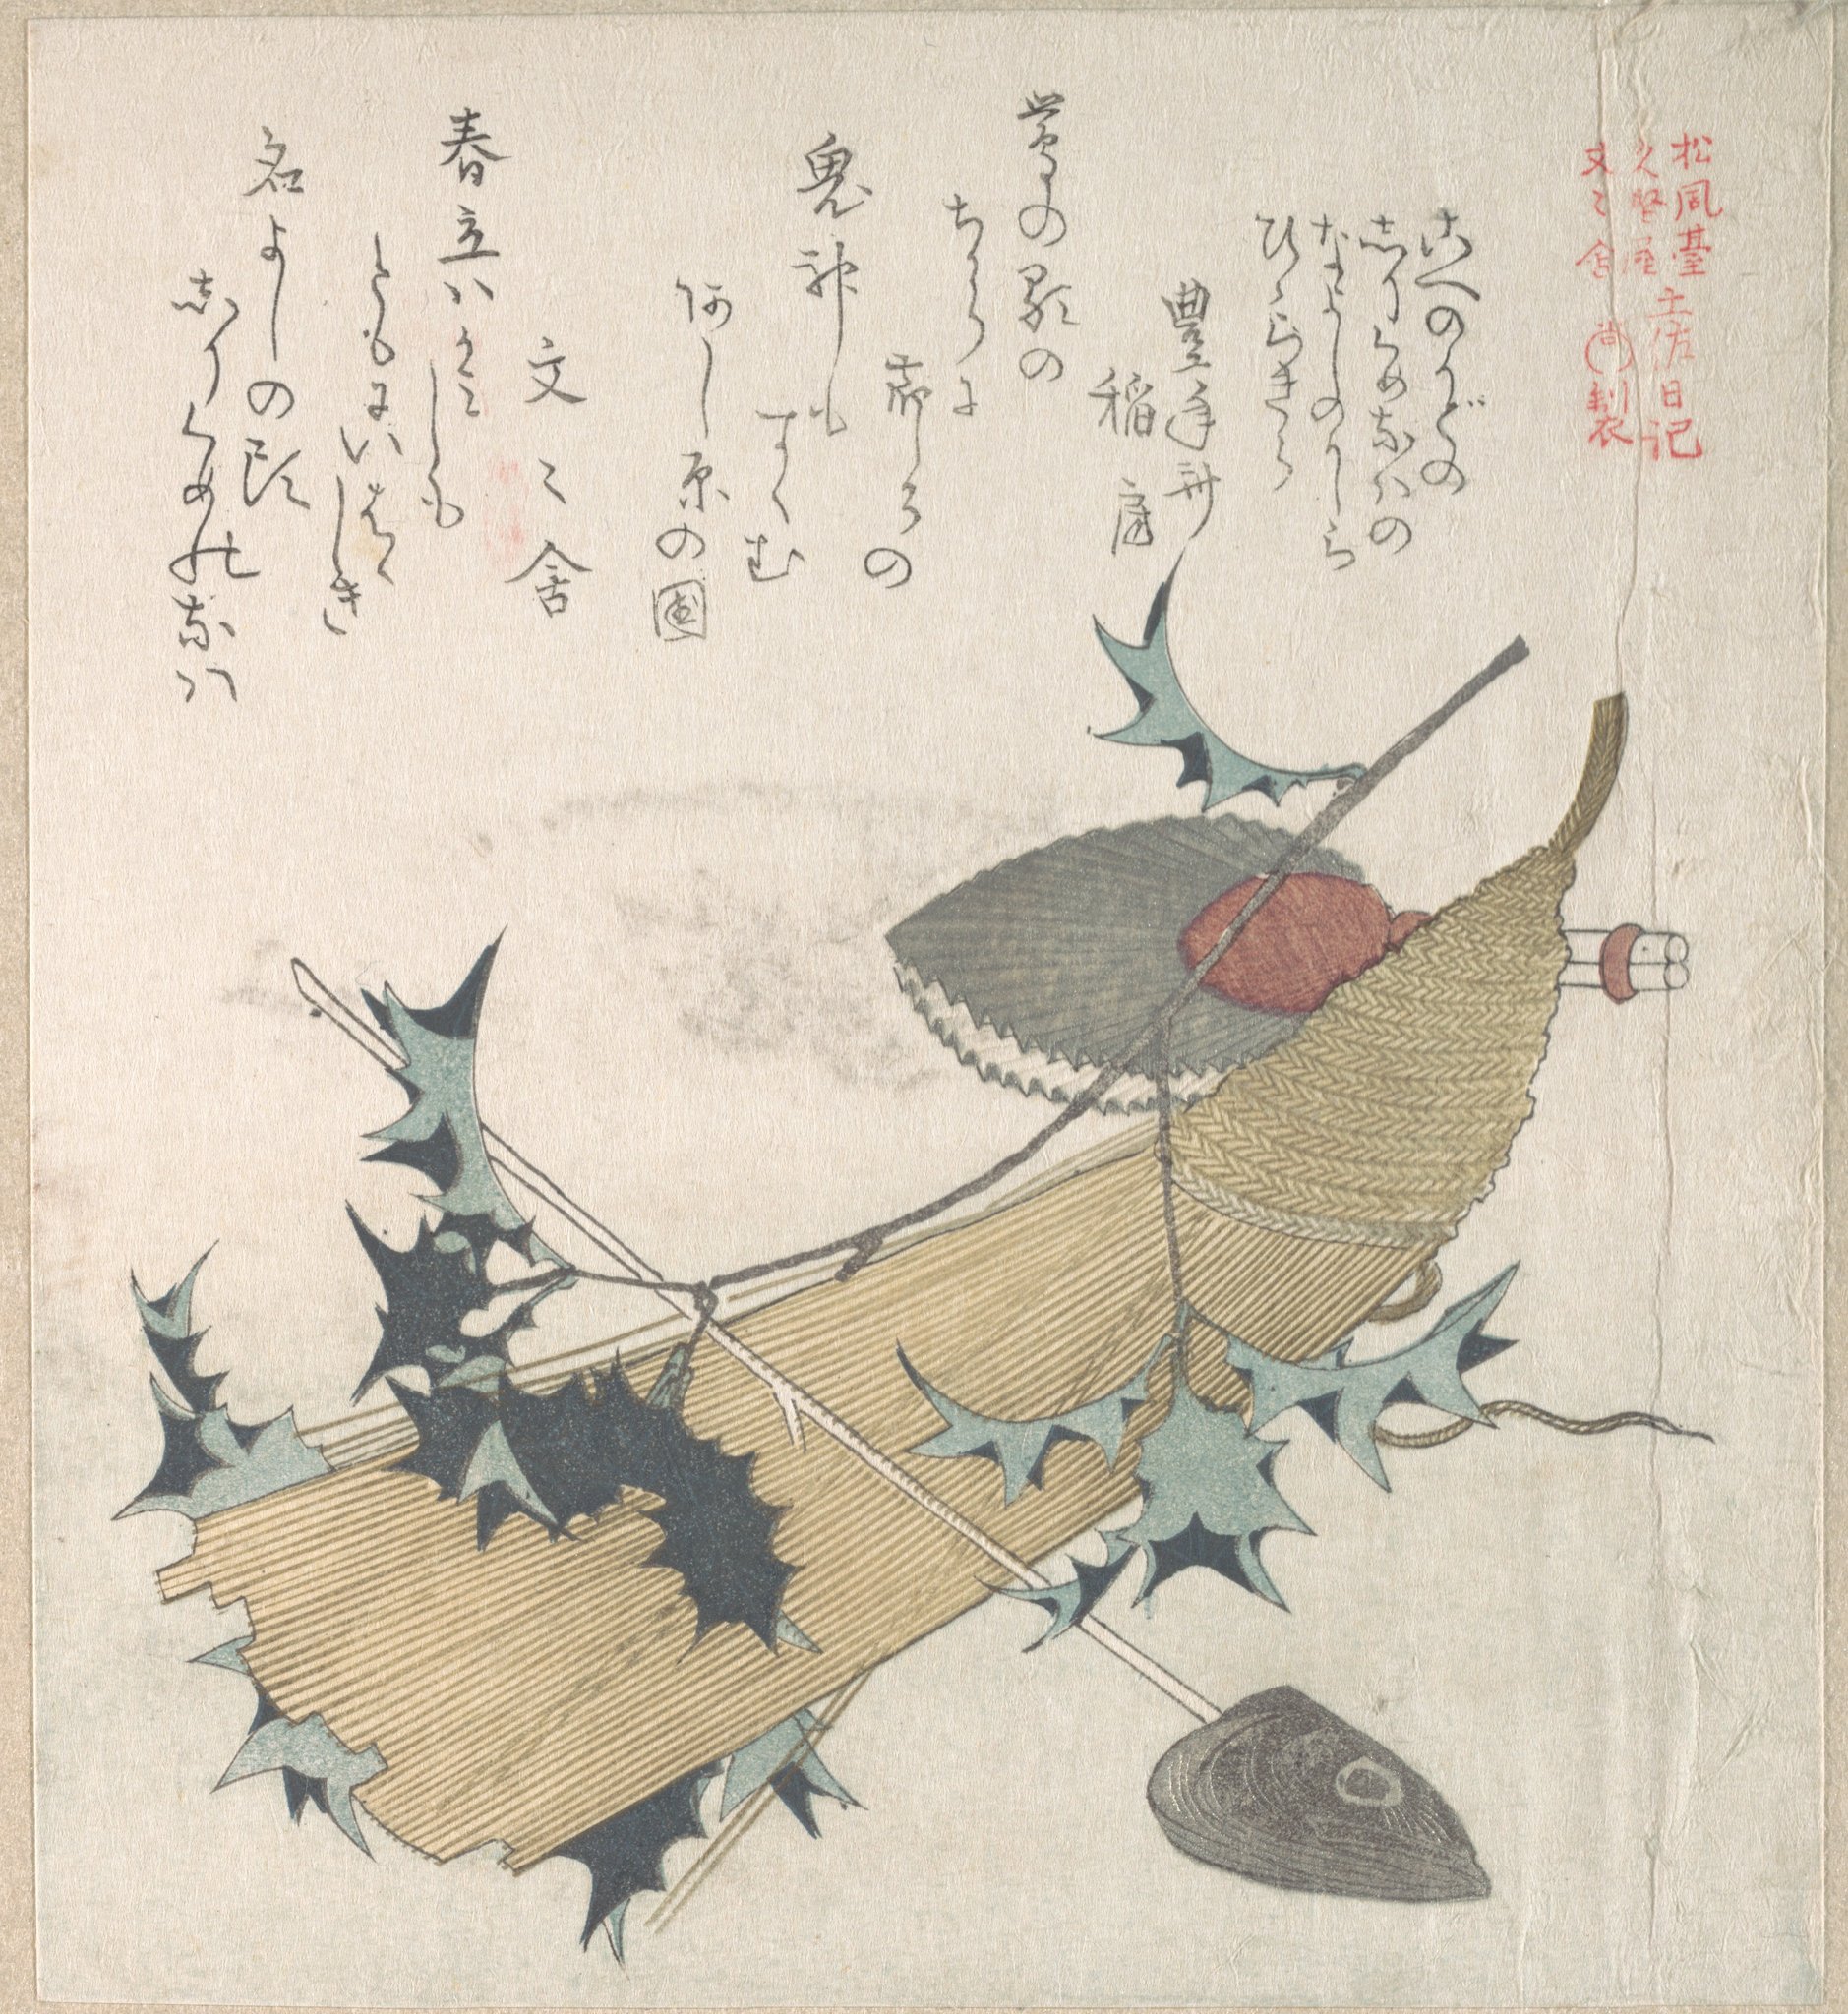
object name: print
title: Objects Representing the Ceremony of Exorcising Demons, One of the New Year Performances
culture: japanese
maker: kubo shunman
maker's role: artist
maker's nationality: japanese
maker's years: 1757-1820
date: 1801-1900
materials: ink, paper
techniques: surimono, woodblock print